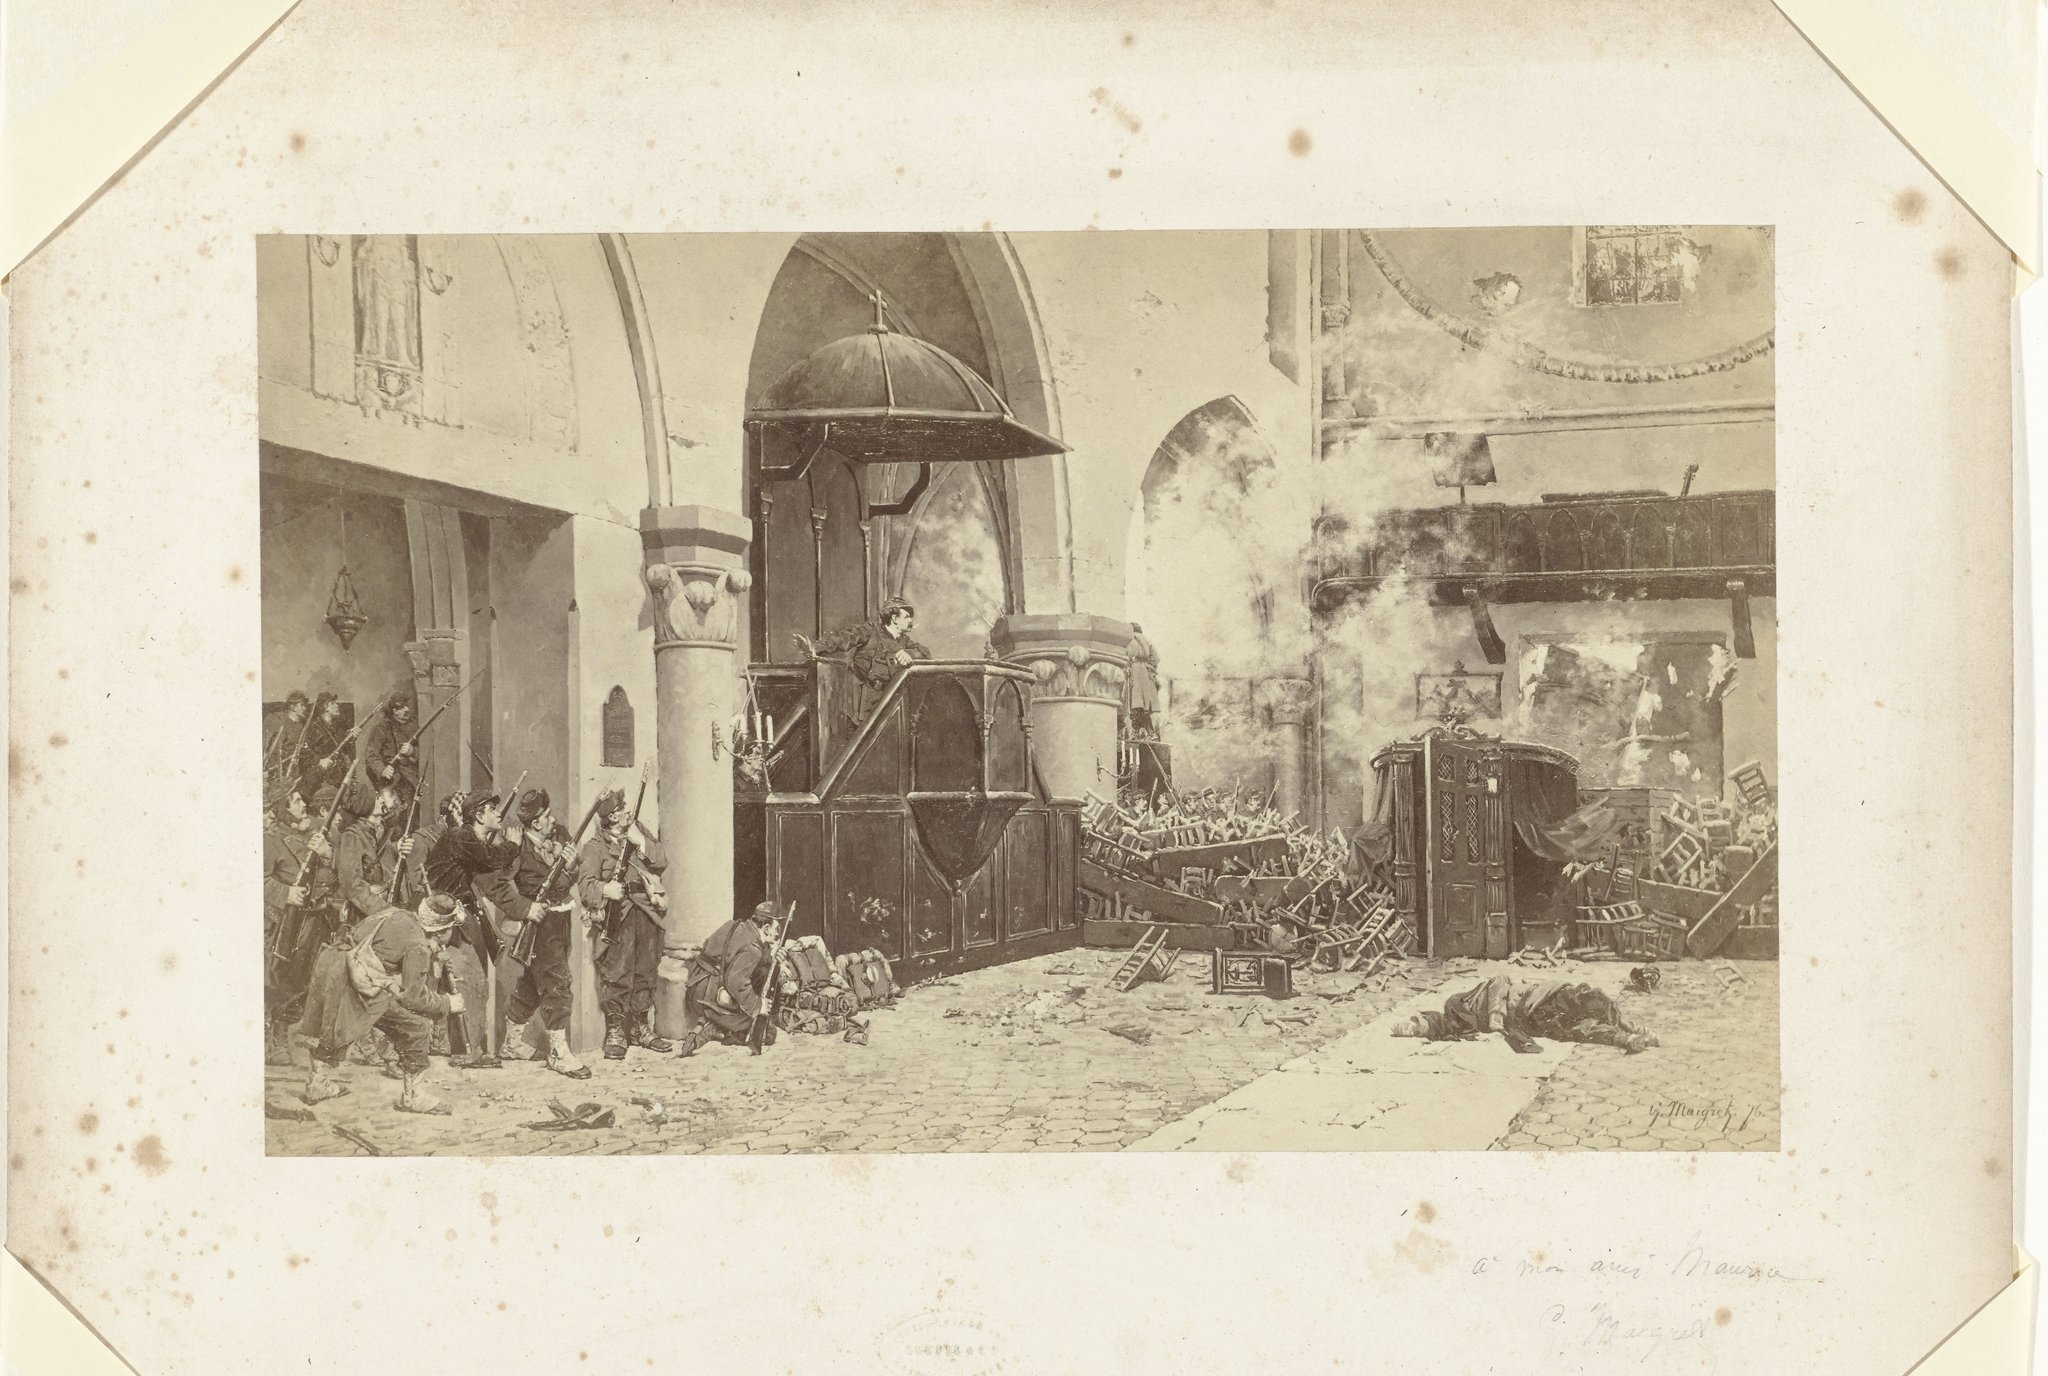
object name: reproduction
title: Fotoreproductie van het schilderij 'Soldats retranchés dans une église' door Georges-Edmond Maigret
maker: georges-edmond maigret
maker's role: painter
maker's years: 1846-1929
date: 1876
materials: cardboard, paper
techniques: albumen print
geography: paris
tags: battle, interior of church, france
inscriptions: check stamp: ‘Photographié par/ Goupil & Cie/ Editeur à Paris’, inscription: ‘à mon ami Maurice/ G. Maigret’